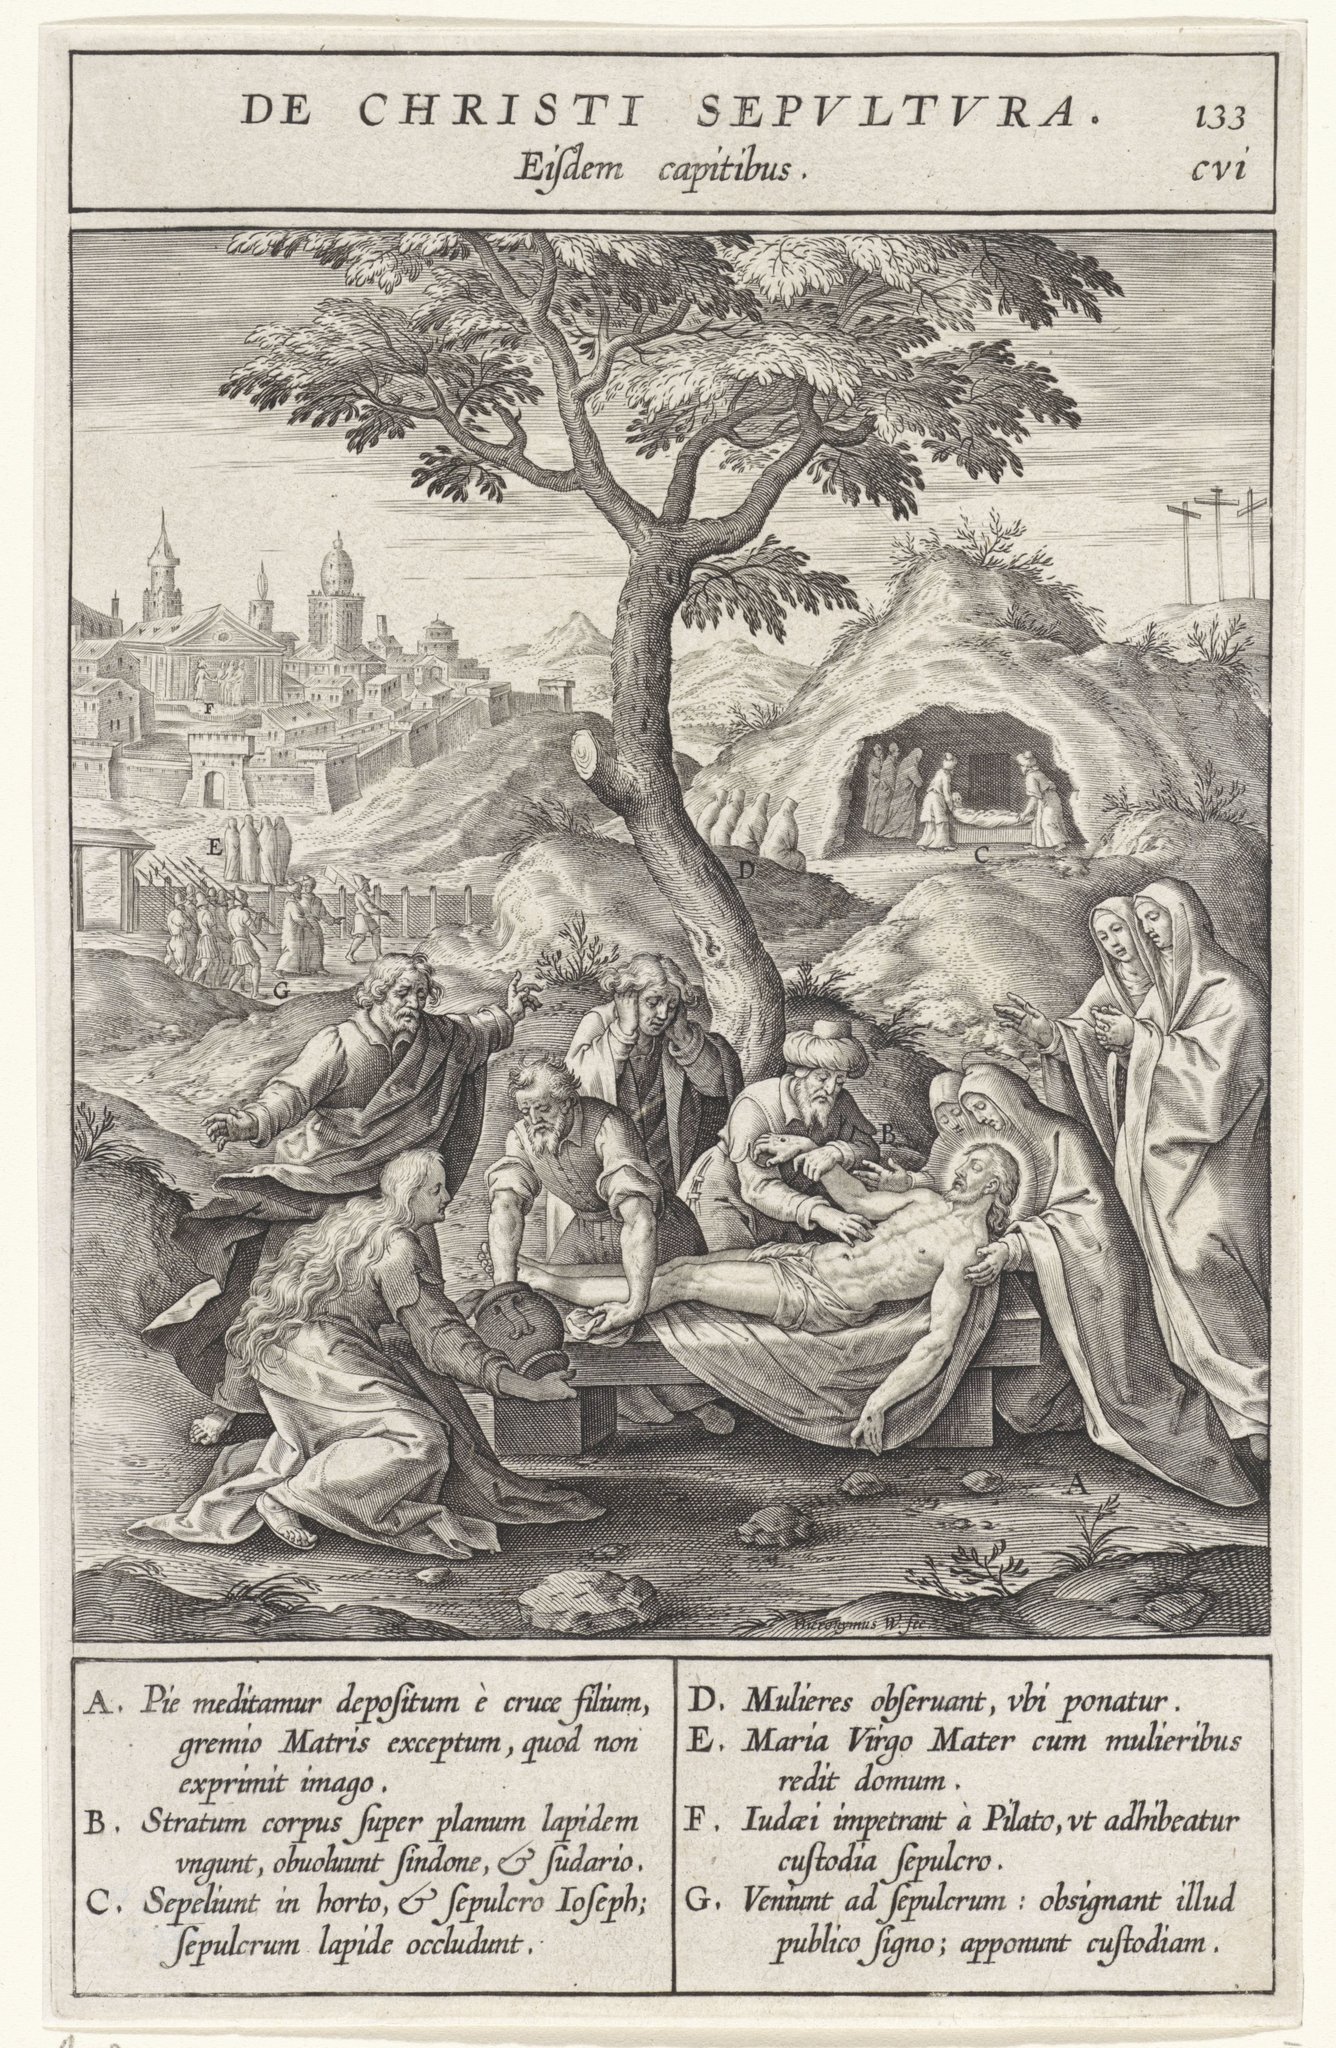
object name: print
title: Graflegging van Christus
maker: hieronymus wierix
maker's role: draughtsman, print maker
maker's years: 1553-1619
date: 1593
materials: paper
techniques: engraving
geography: antwerp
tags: christ's entombment (possibly by angels)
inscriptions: collector's mark: Lugt 2165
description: Christus wordt door Jozef van Arimatea en Nikodemus in het rotsgraf gelegd. Rond hem treurende vrouwen onder wie Maria en Maria Magdalena. Bij verschillende elementen uit de voorstelling staan letters die corresponderen met de legenda in de marge.